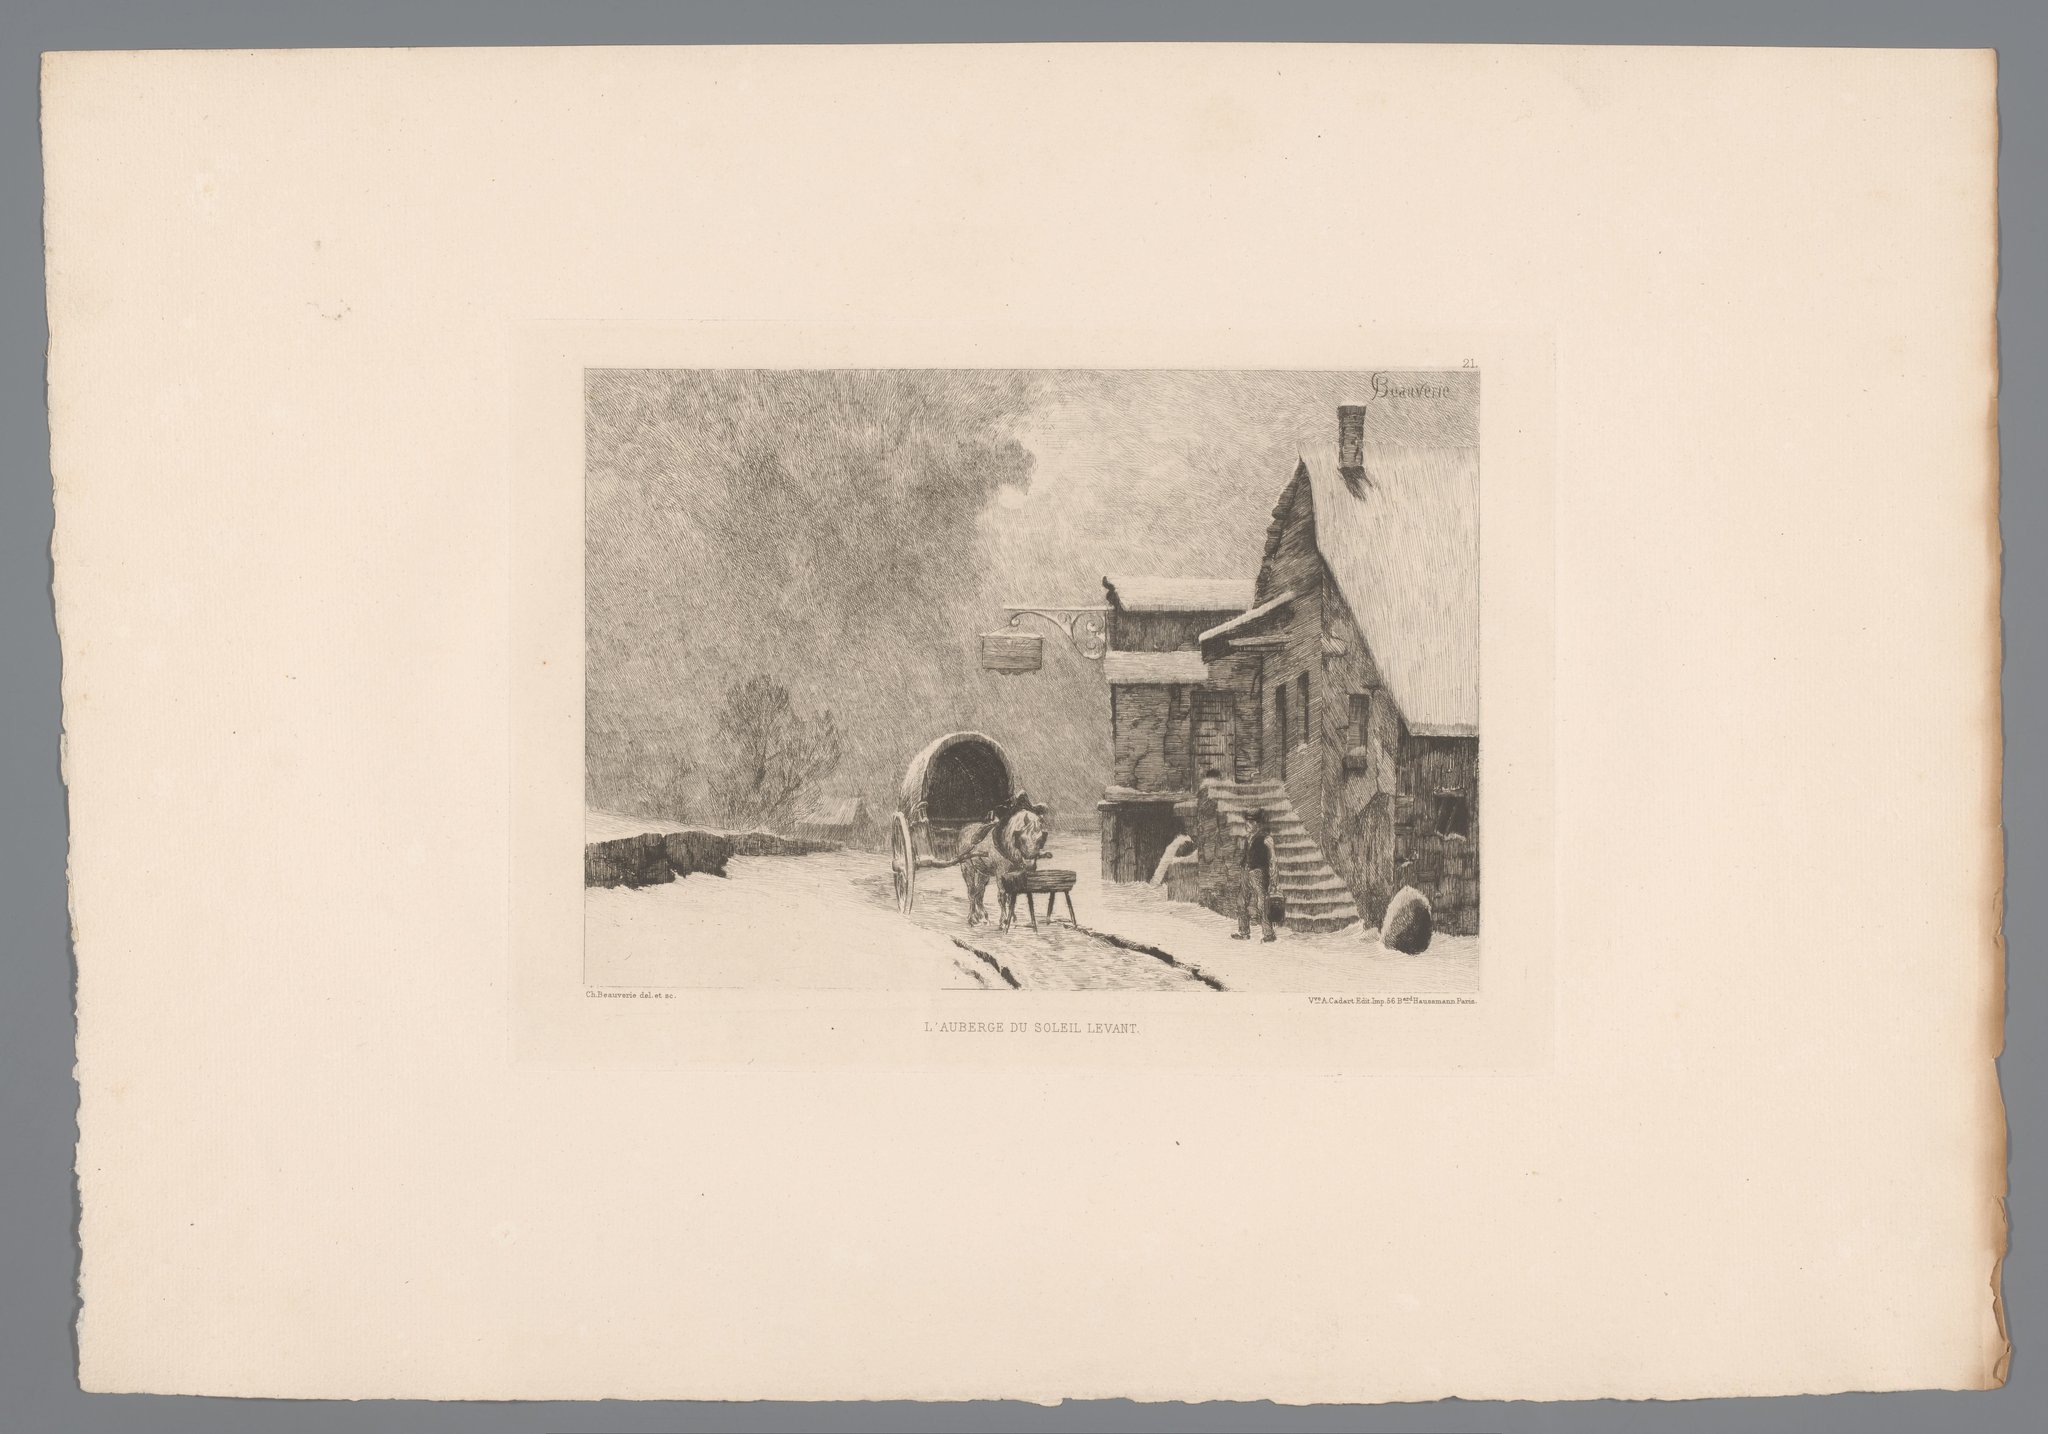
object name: print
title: Herberg in de sneeuw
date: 1878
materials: paper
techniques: drypoint, etching, intaglio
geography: paris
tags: snow, hotel, hostelry, inn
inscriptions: collector's mark: Lugt 2760, collector's mark: Lugt 2228, collector's mark: ‘AFE v S’, watermark